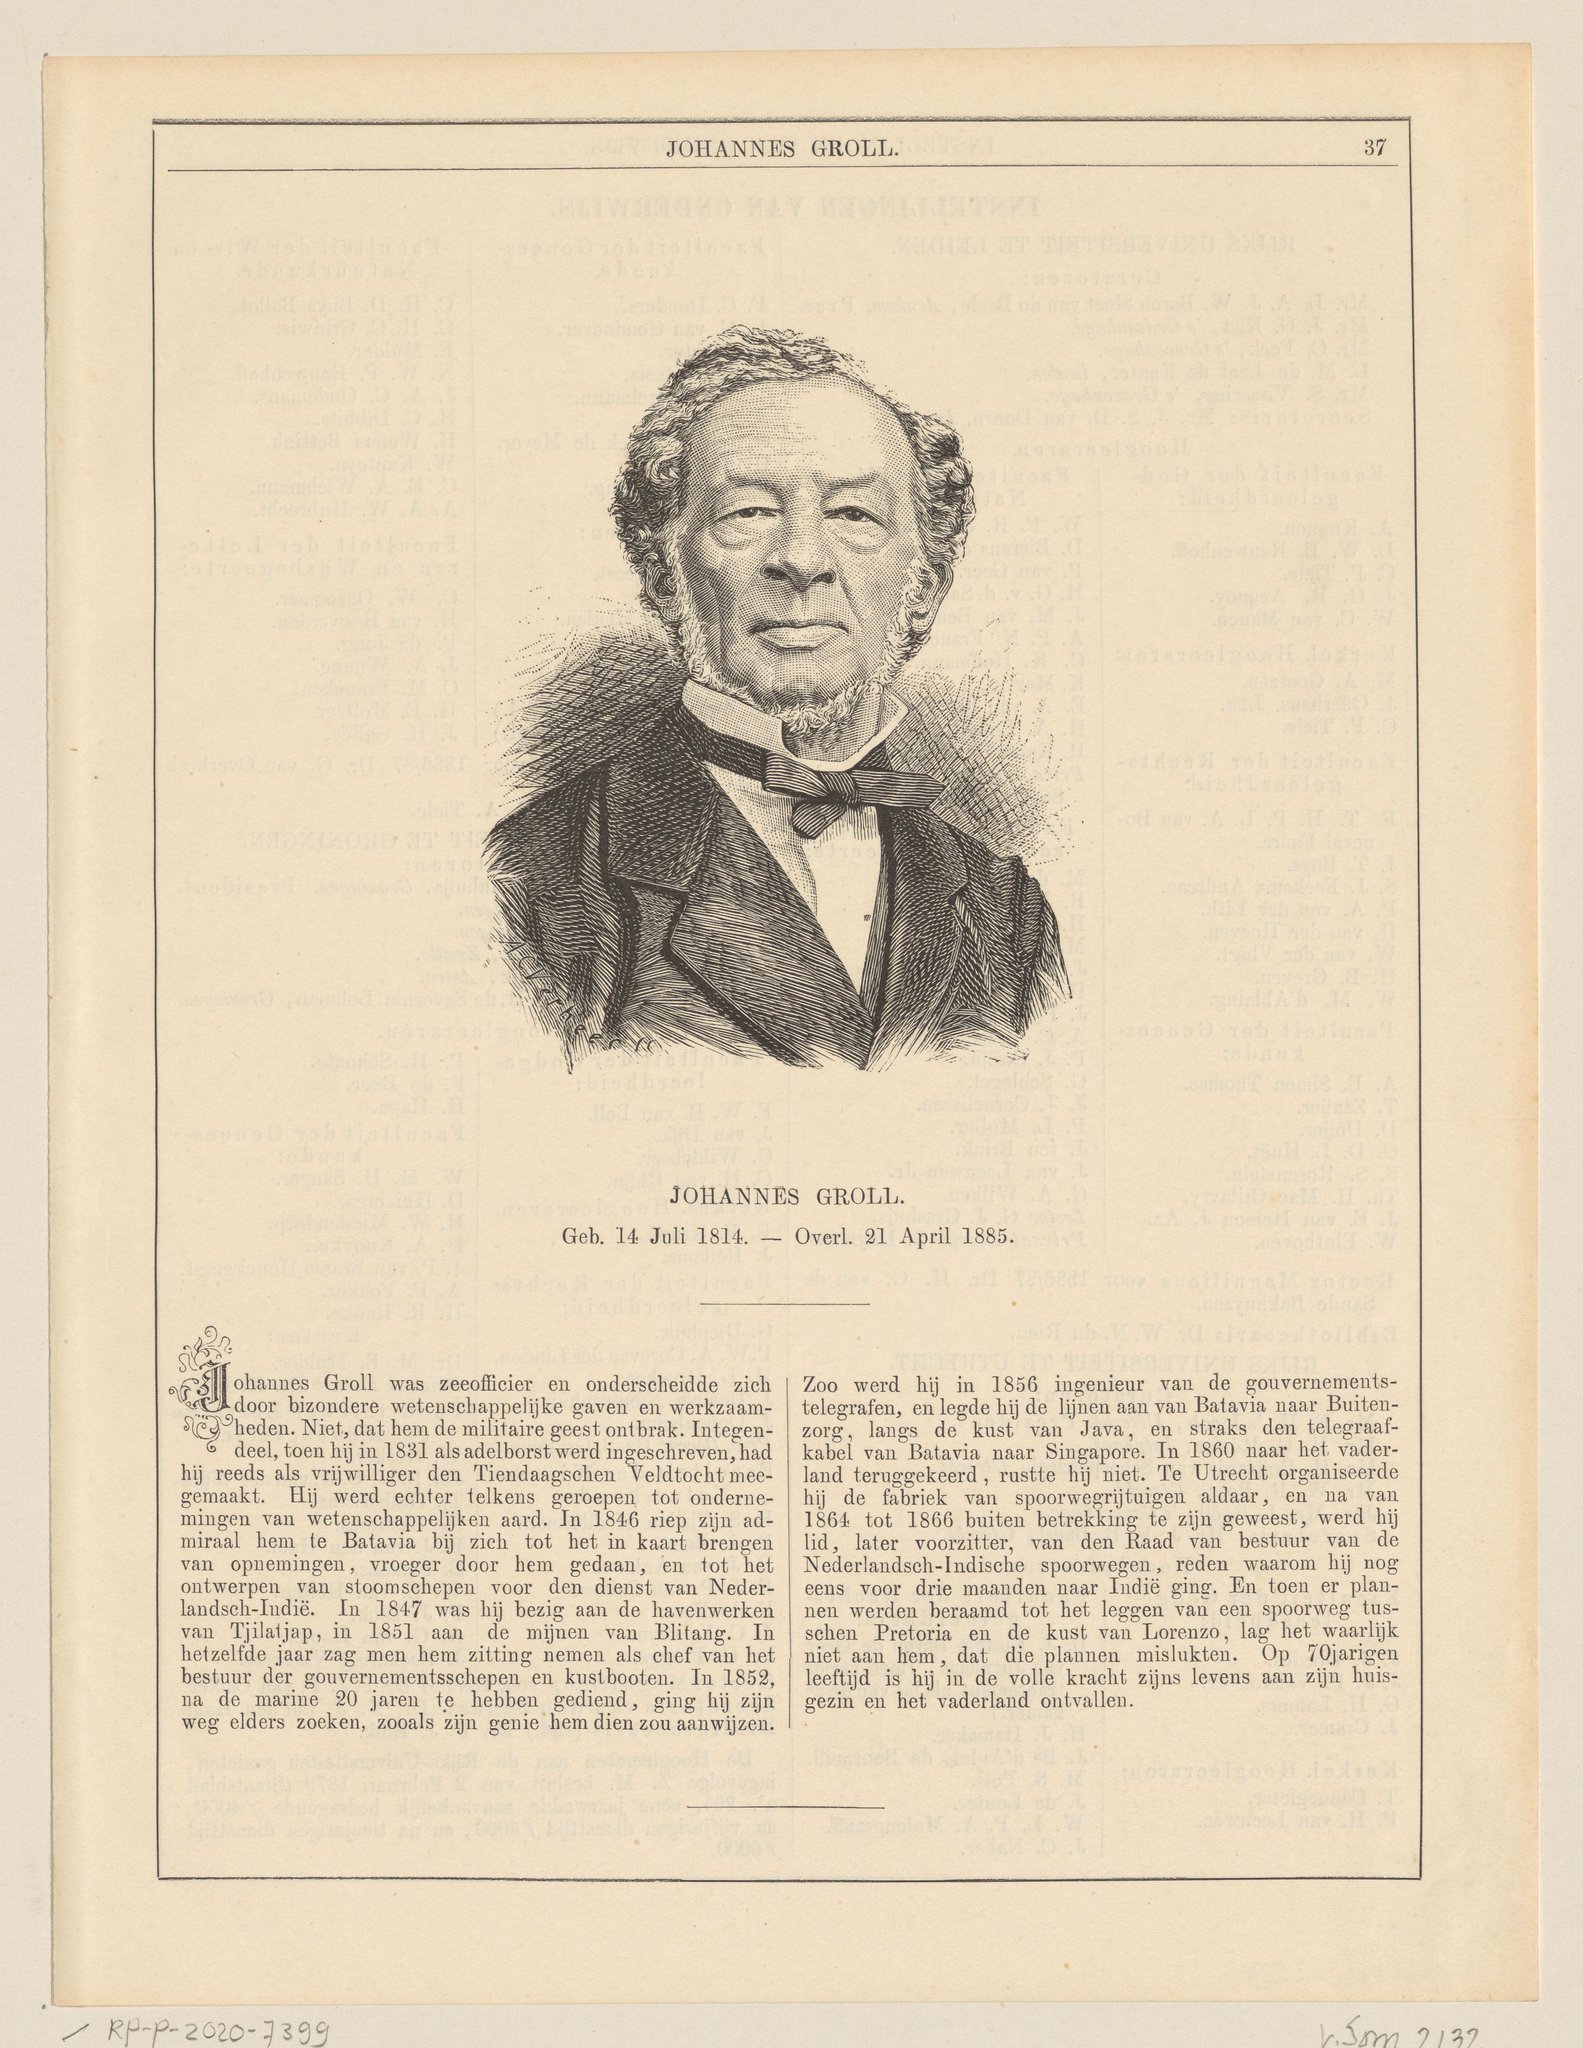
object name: print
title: Portret van Johannes Groll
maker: arnoldus cornelius verhees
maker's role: print maker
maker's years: 1859-1929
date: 1885-1887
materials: paper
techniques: letterpress printing, engraving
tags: abcoude, historical persons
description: Tekst in het Nederlands in de ondermarge.